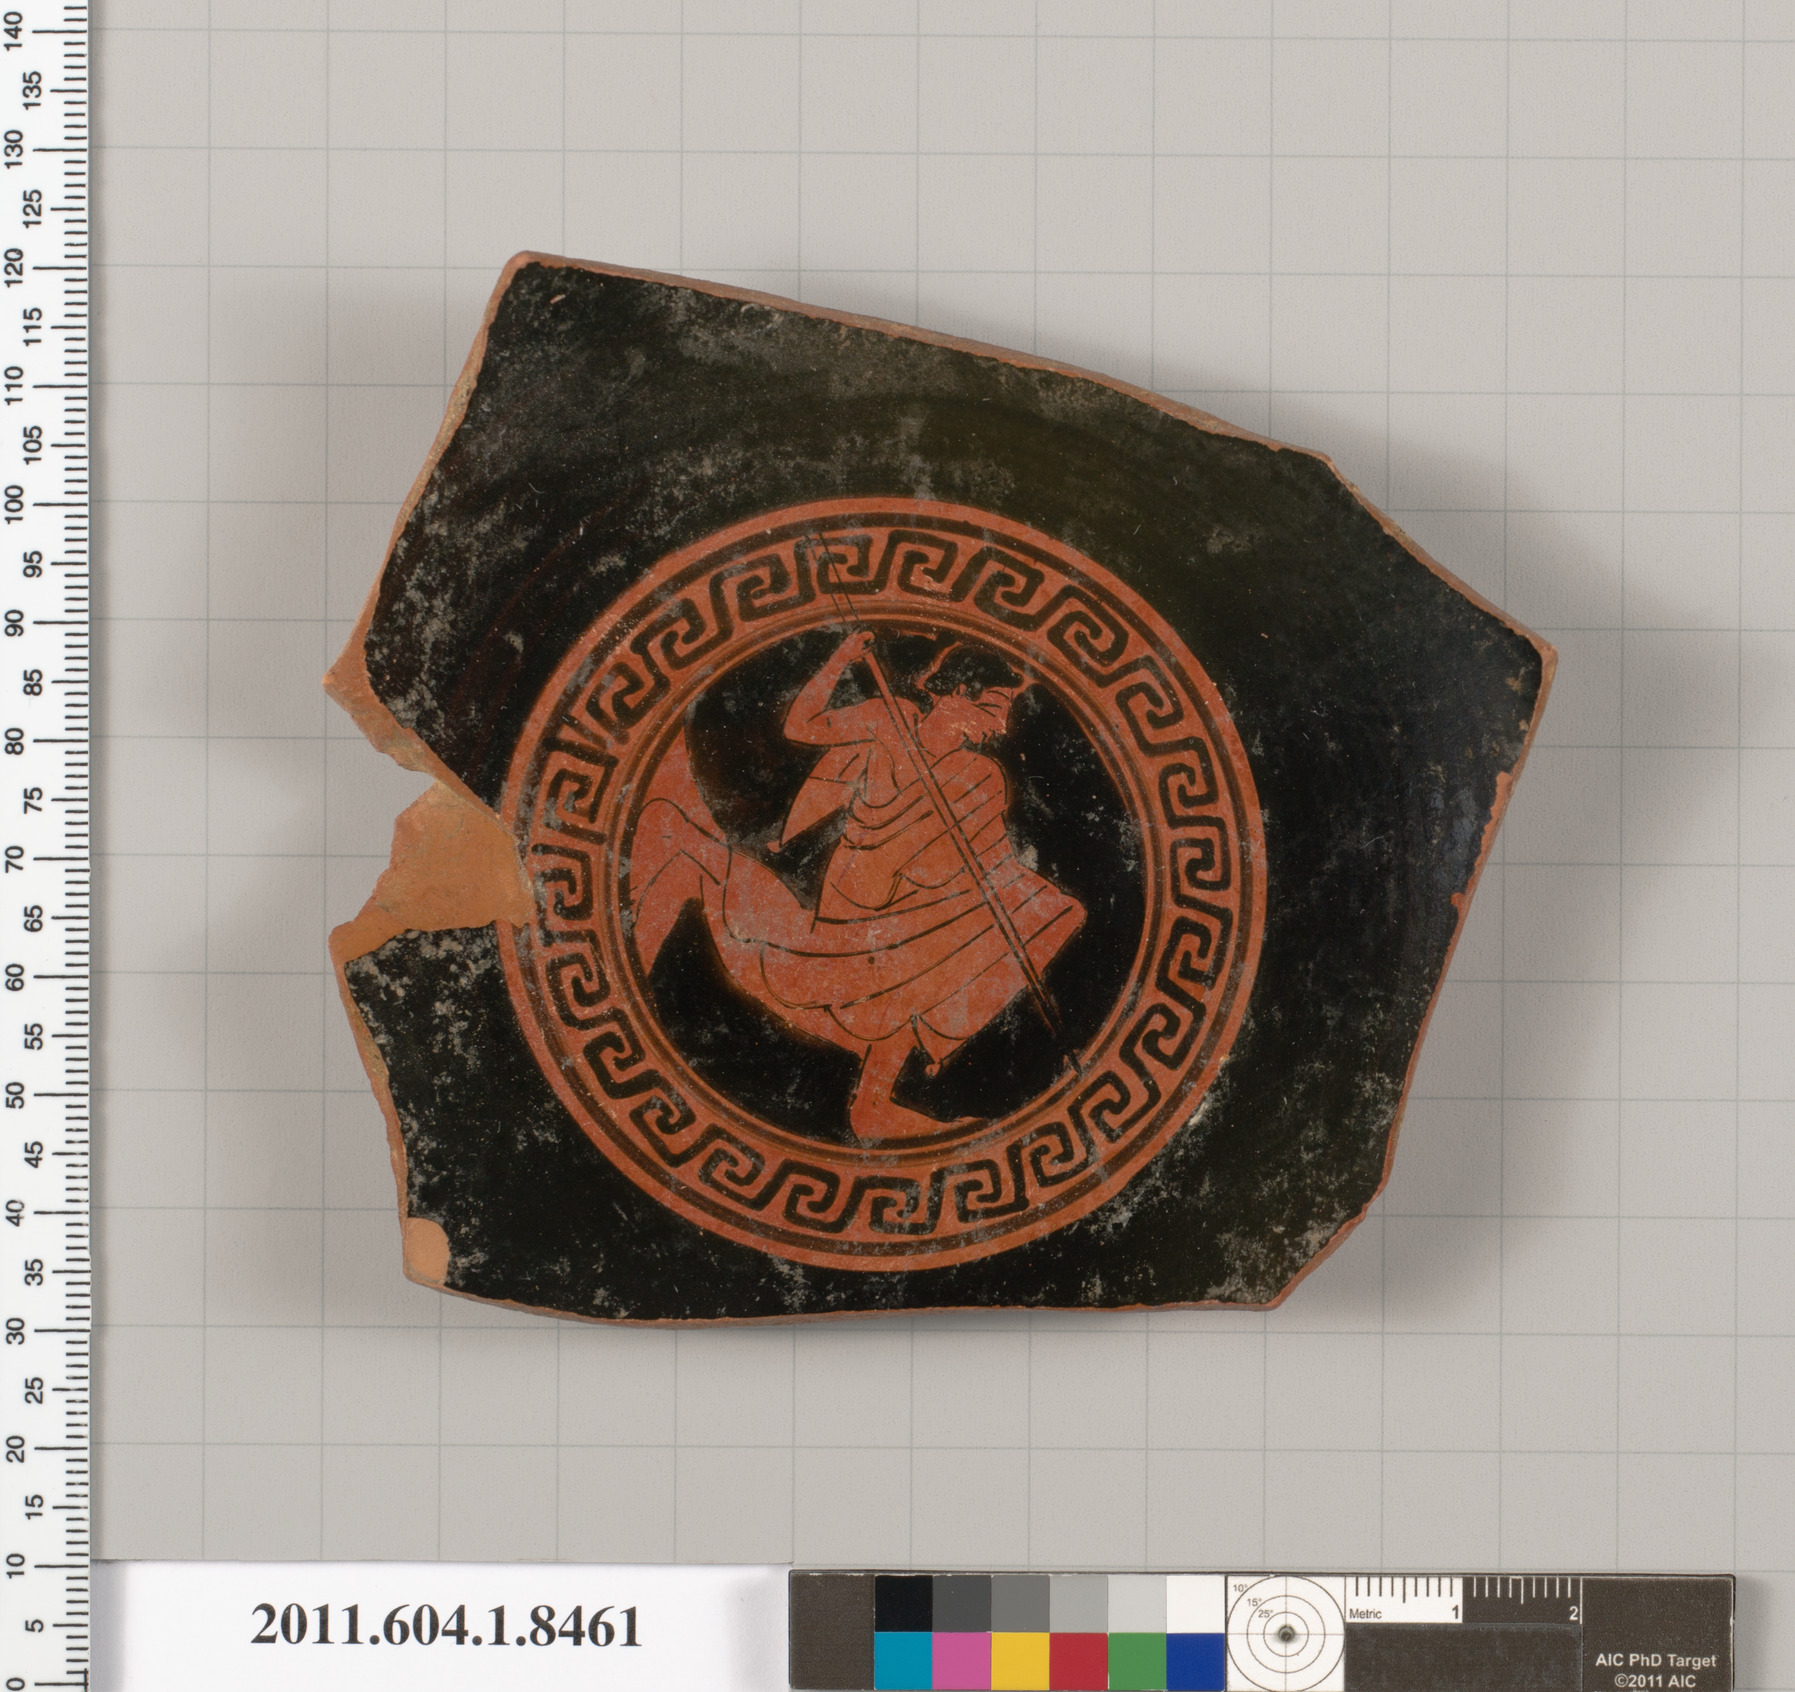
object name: kylix fragment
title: Terracotta fragment of a stemless kylix (drinking cup)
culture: greek, attic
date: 451-500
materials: terracotta